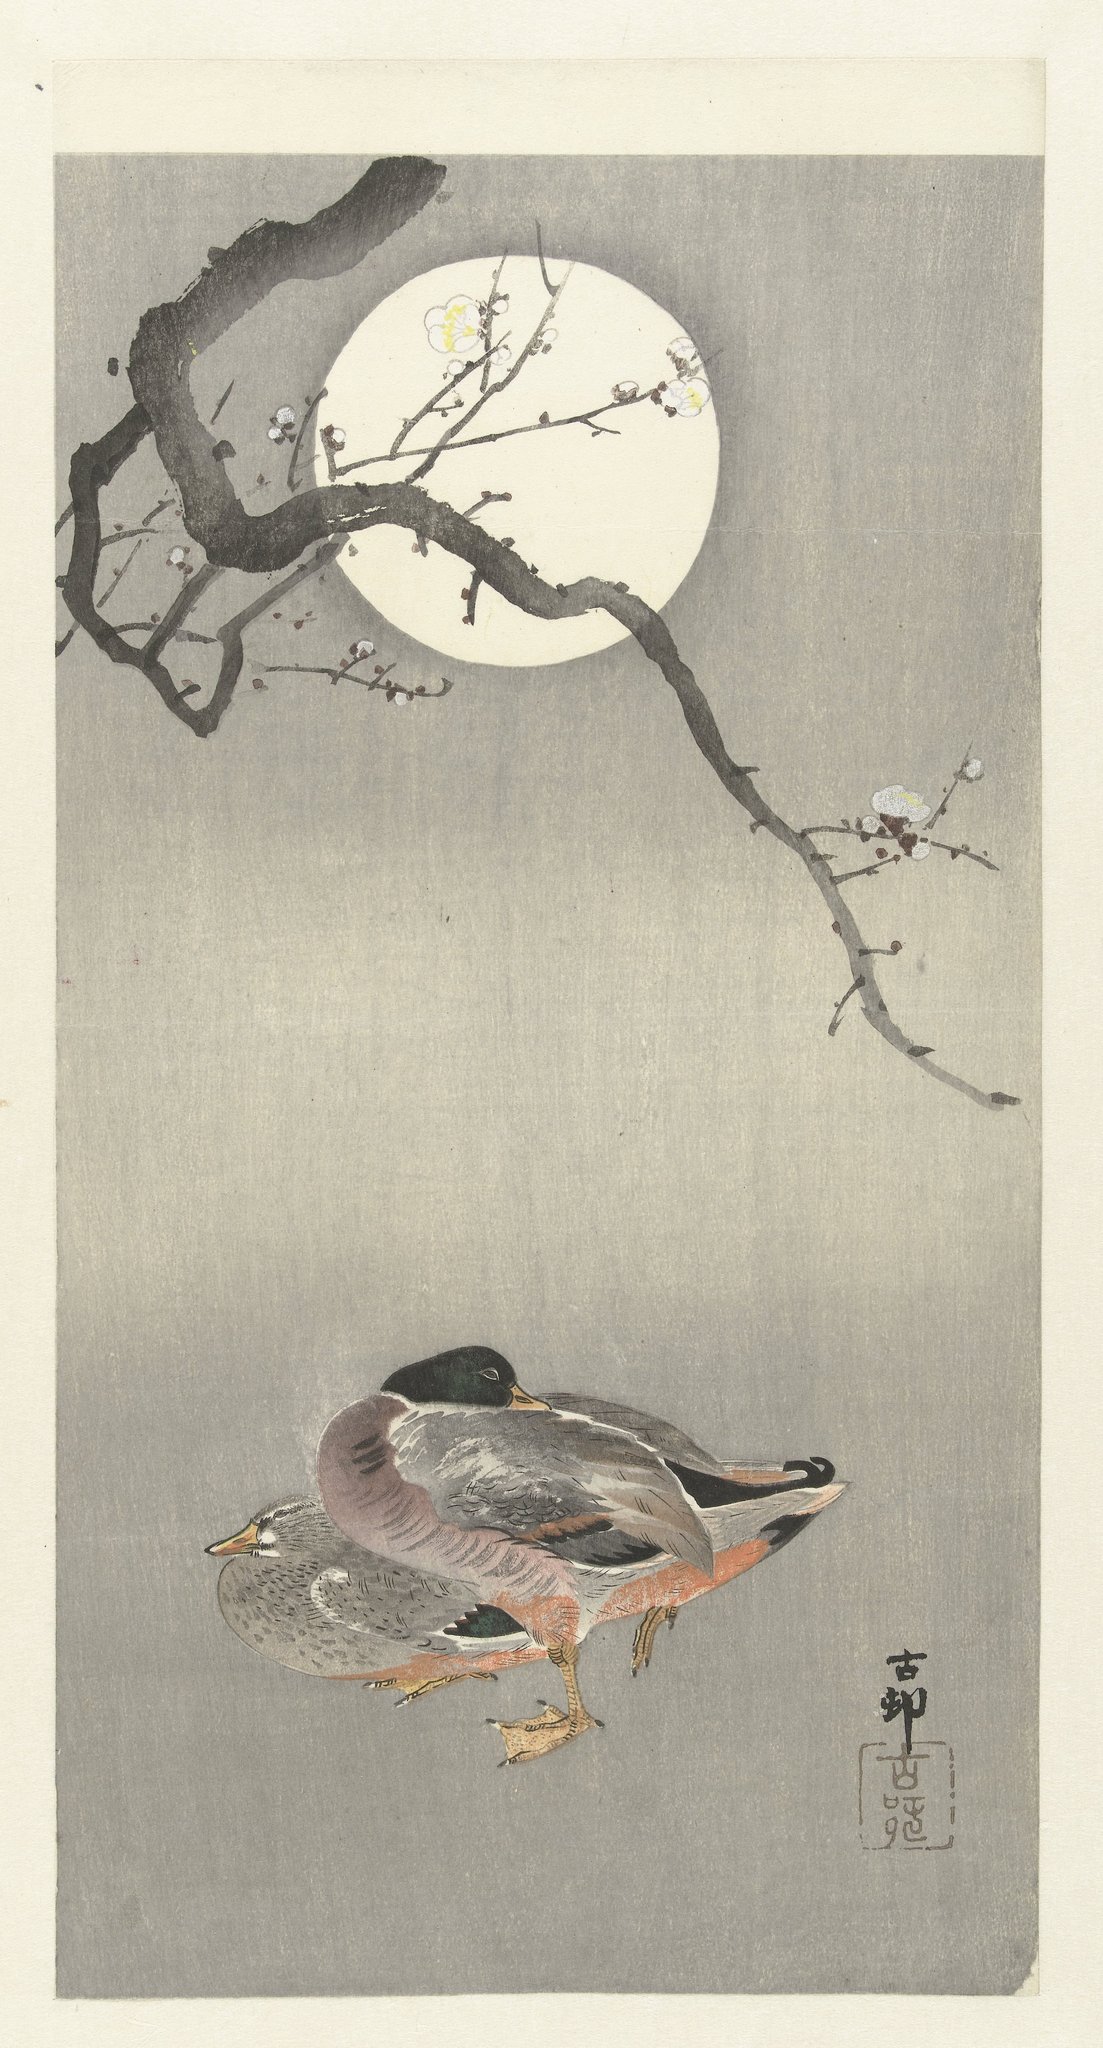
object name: print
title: Eenden bij volle maan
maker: ohara koson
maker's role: print maker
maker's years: 1877-1945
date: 1900-1945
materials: paper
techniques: woodcut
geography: japan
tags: full moon, water-birds: duck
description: Koppel eenden, onder bloesemtak, bij volle maan.